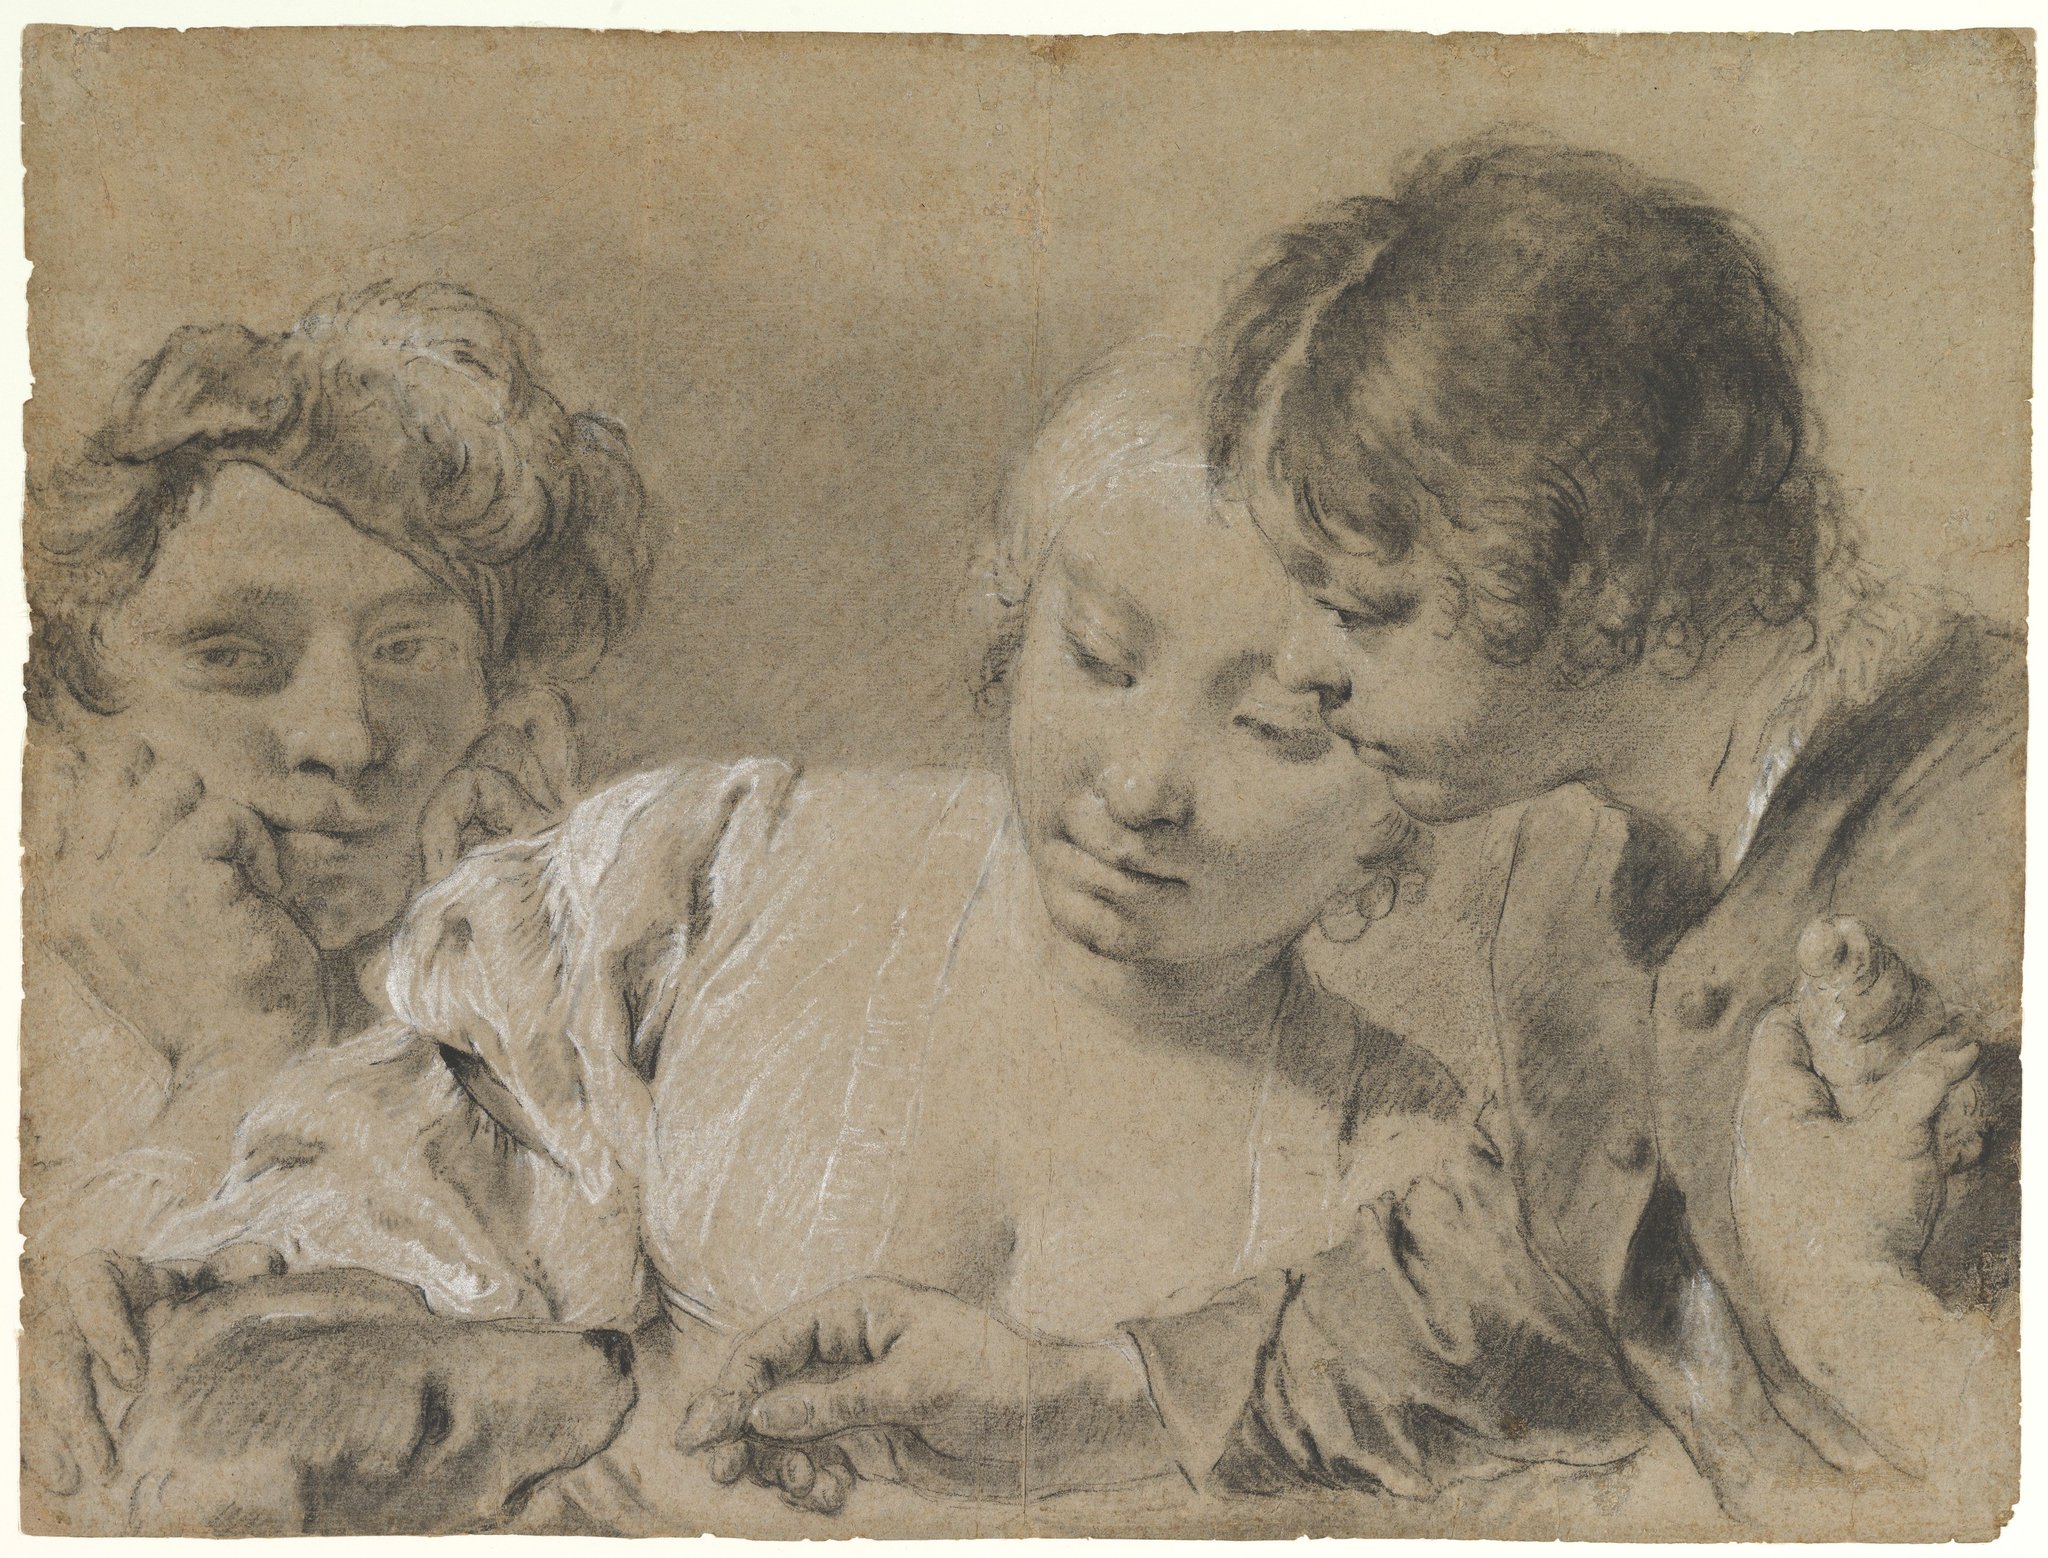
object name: drawing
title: Feeding the Dog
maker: giovanni battista piazzetta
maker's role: artist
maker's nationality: italian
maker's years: 1682-1754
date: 1682-1754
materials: chalk, paper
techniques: highlighting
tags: boys,girls,dogs